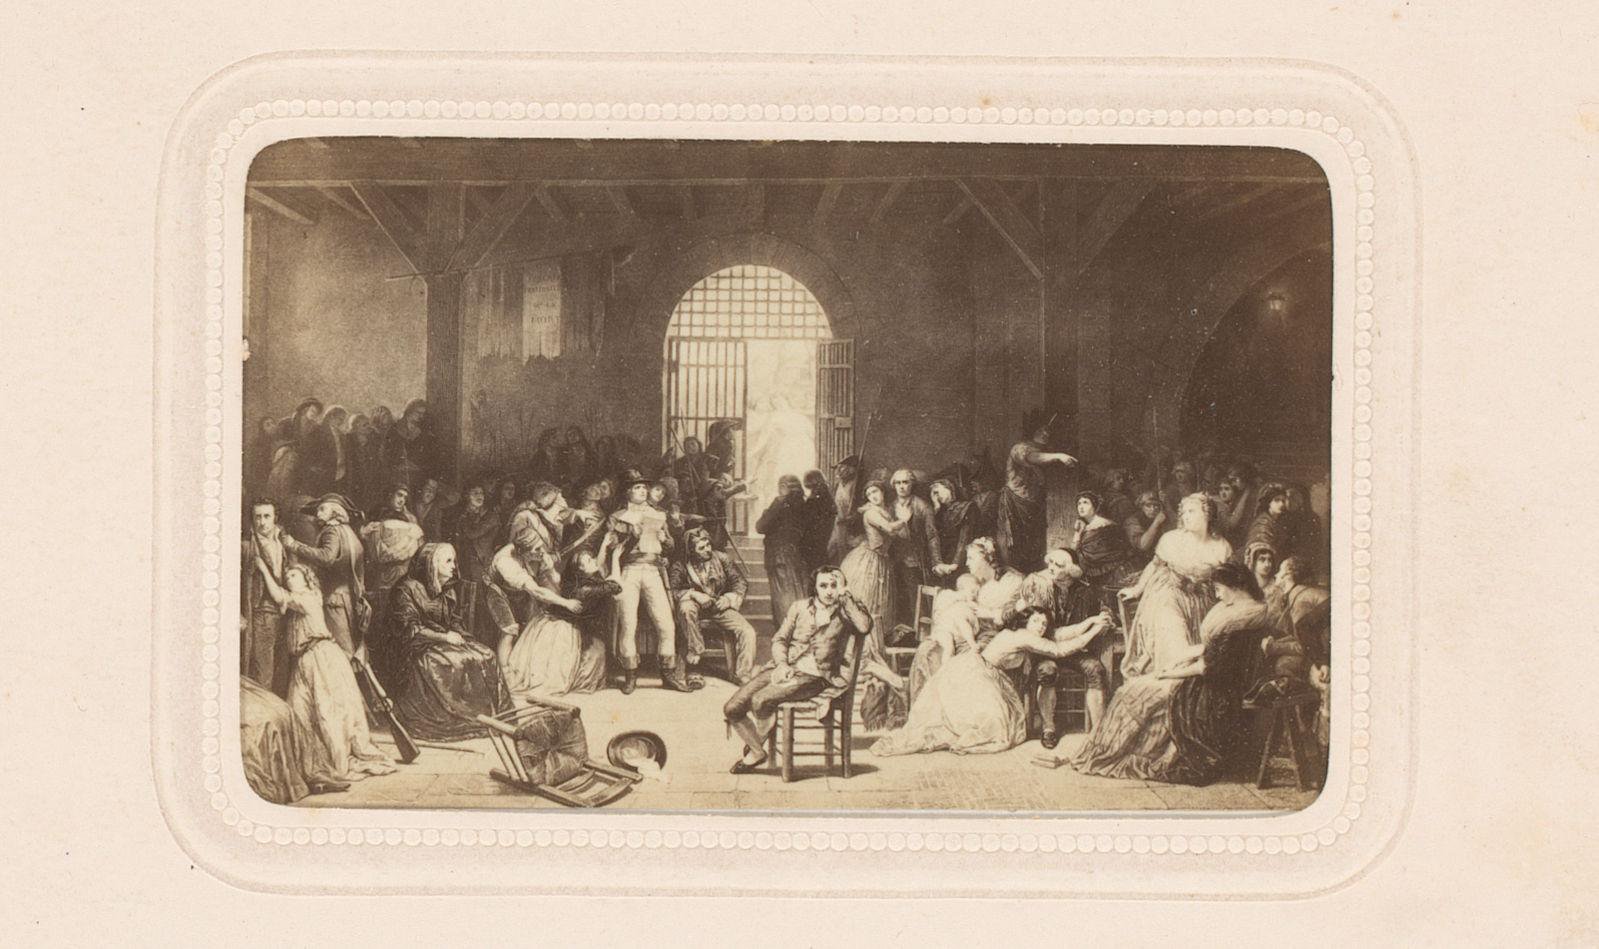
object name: album leaf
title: Fotoreproductie van L'appel des dernières victimes de la Terreur door Charles Louis Lucien Muller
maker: charles louis lucien muller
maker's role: painter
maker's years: 1815-1892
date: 1860-1890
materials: cardboard, photographic support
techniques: albumen print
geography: paris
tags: prison, jail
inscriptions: inscription: ‘No 779/ DERNIERES VICTIMES DE LA TERREUR/ The last victimes of/ the "region of Terror"/ Die letzten Opfer/ der Schreckenszeit/ Peint par Ch. L. Muller/ GOUPIL & Cie/ Éditeurs/ 9, rue Chaptal, 9/ PARIS’